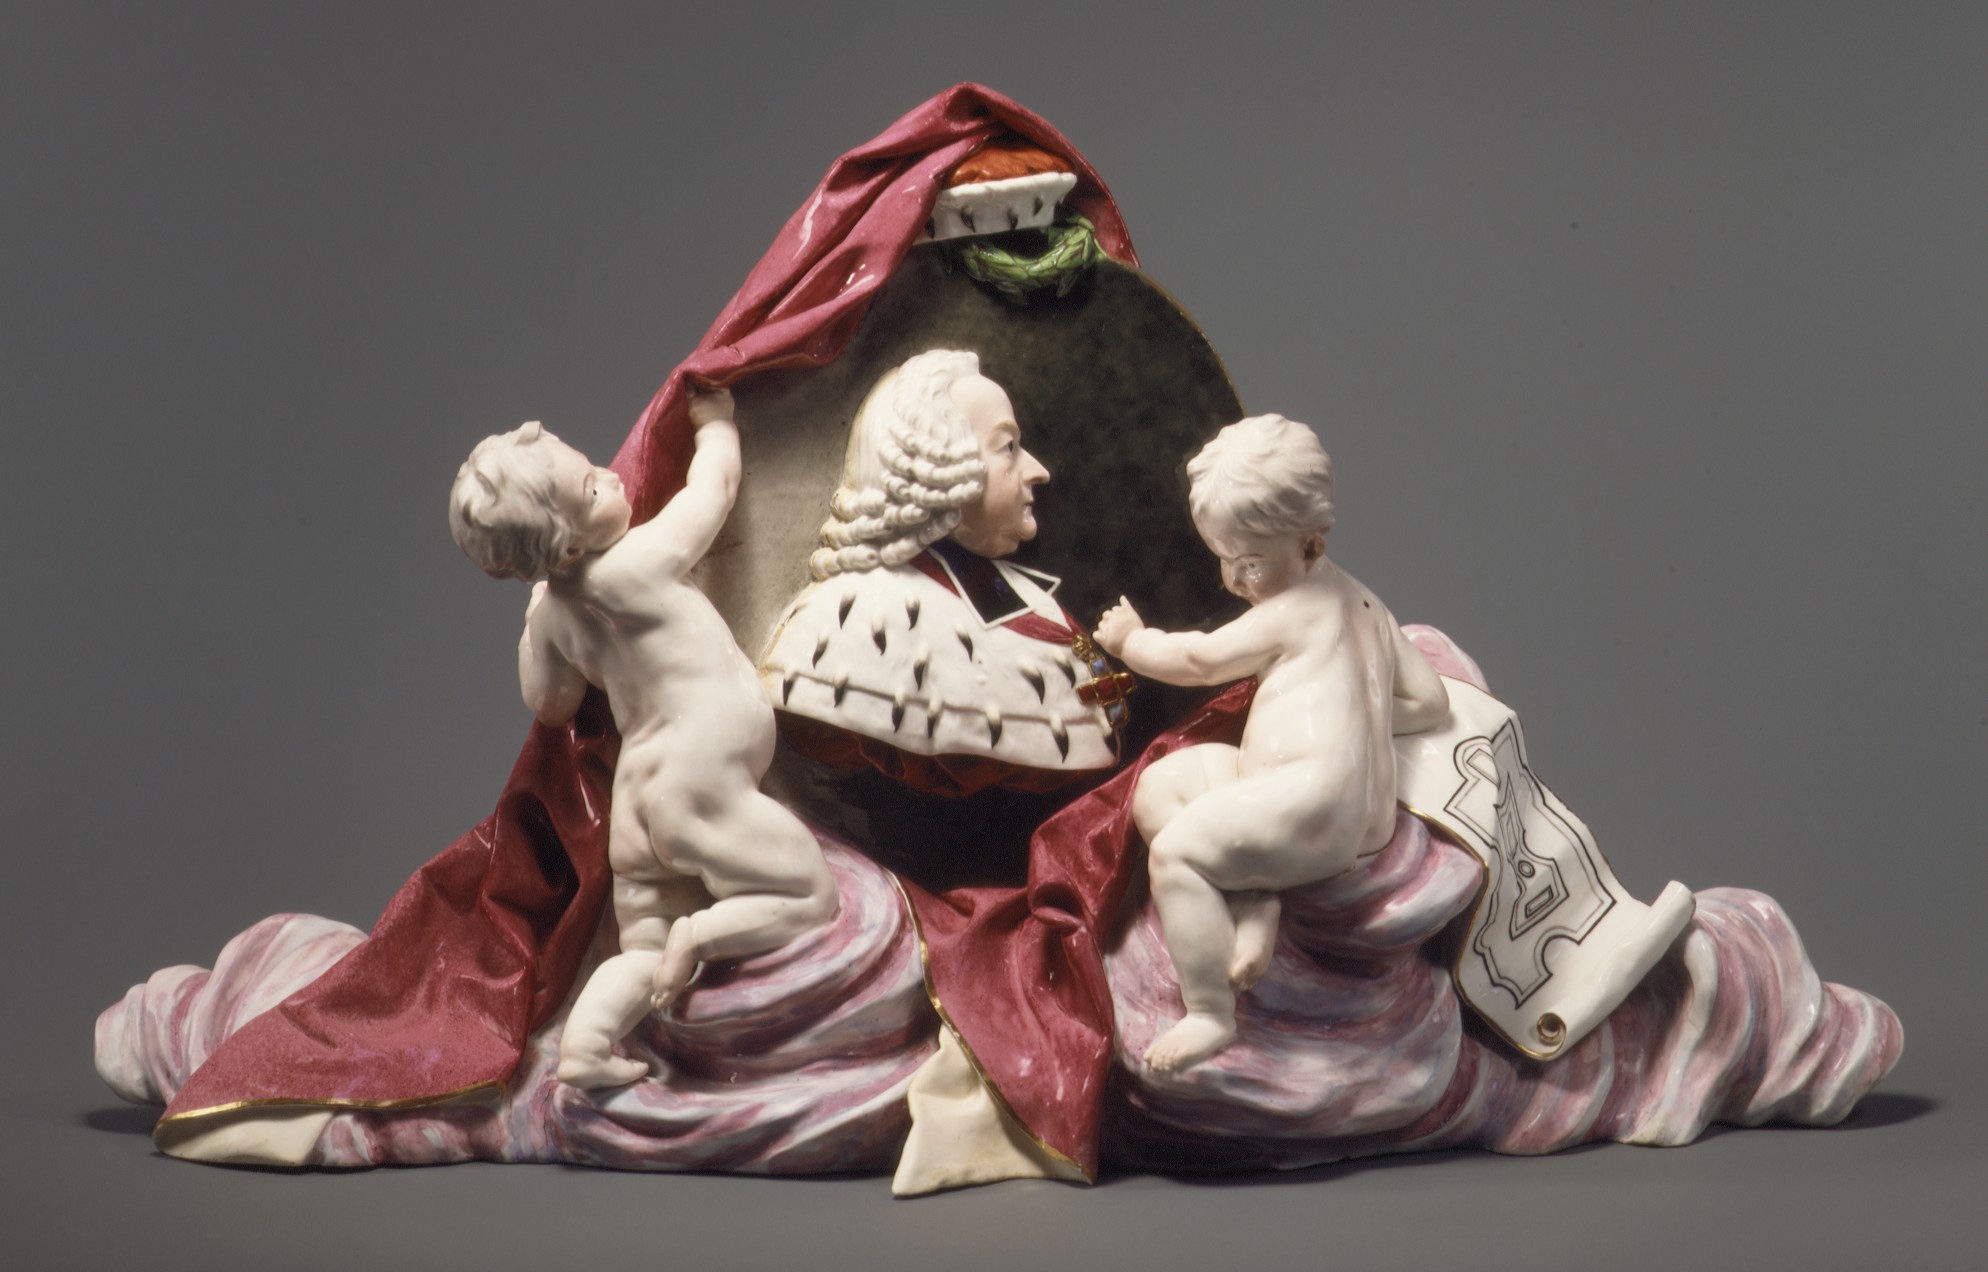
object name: group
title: Emmerich Joseph, Prince-Bishop of Mainz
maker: höchst manufactory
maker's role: manufactory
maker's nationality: german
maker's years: 1746-1796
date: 1770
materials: hard paste porcelain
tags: men,putti